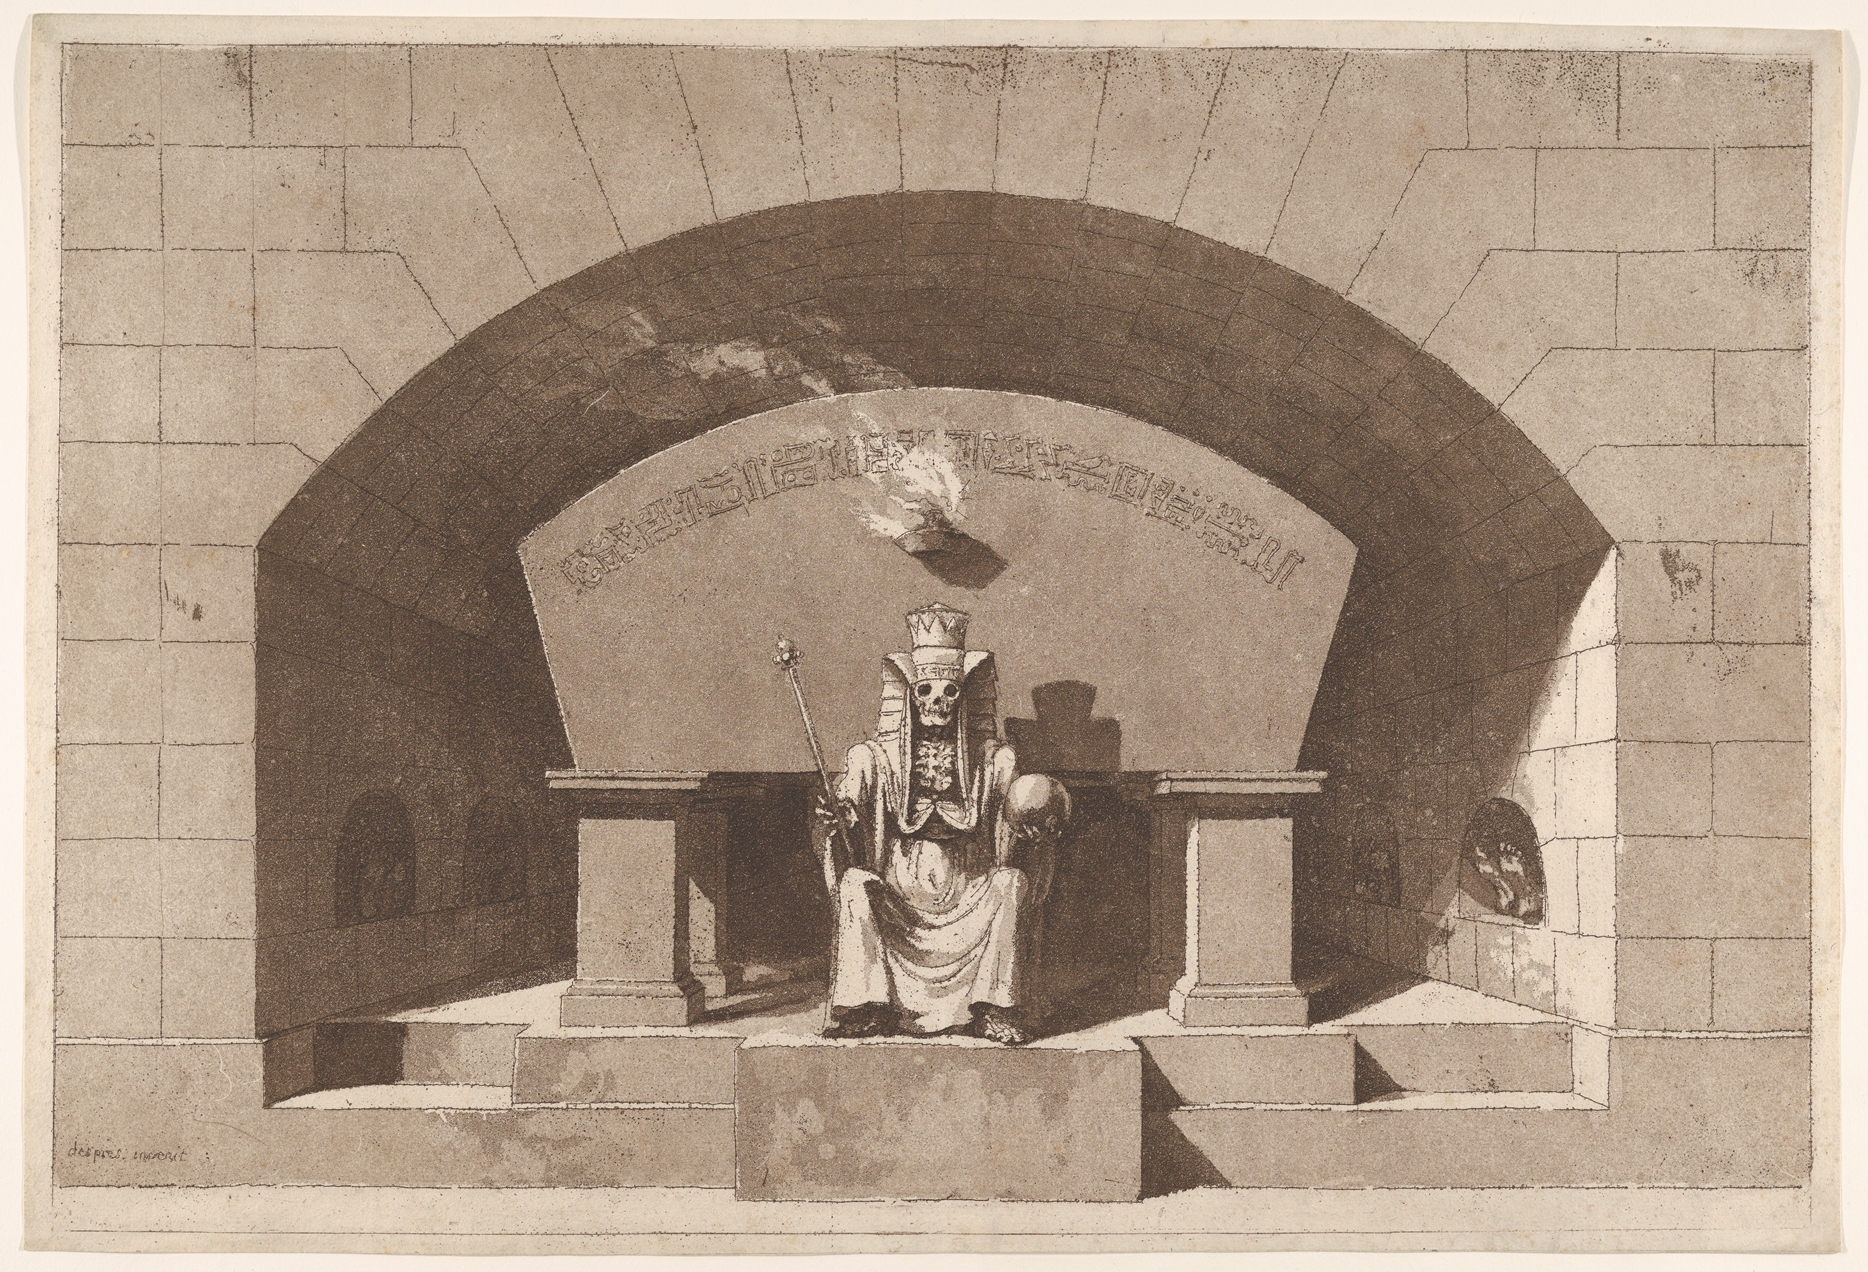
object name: print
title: Tomb with Death Enthroned as a Sphinx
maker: louis jean desprez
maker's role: artist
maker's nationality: french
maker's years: 1743-1804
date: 1779-1784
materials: ink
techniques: aquatint, etching, printing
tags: tombs,skeletons